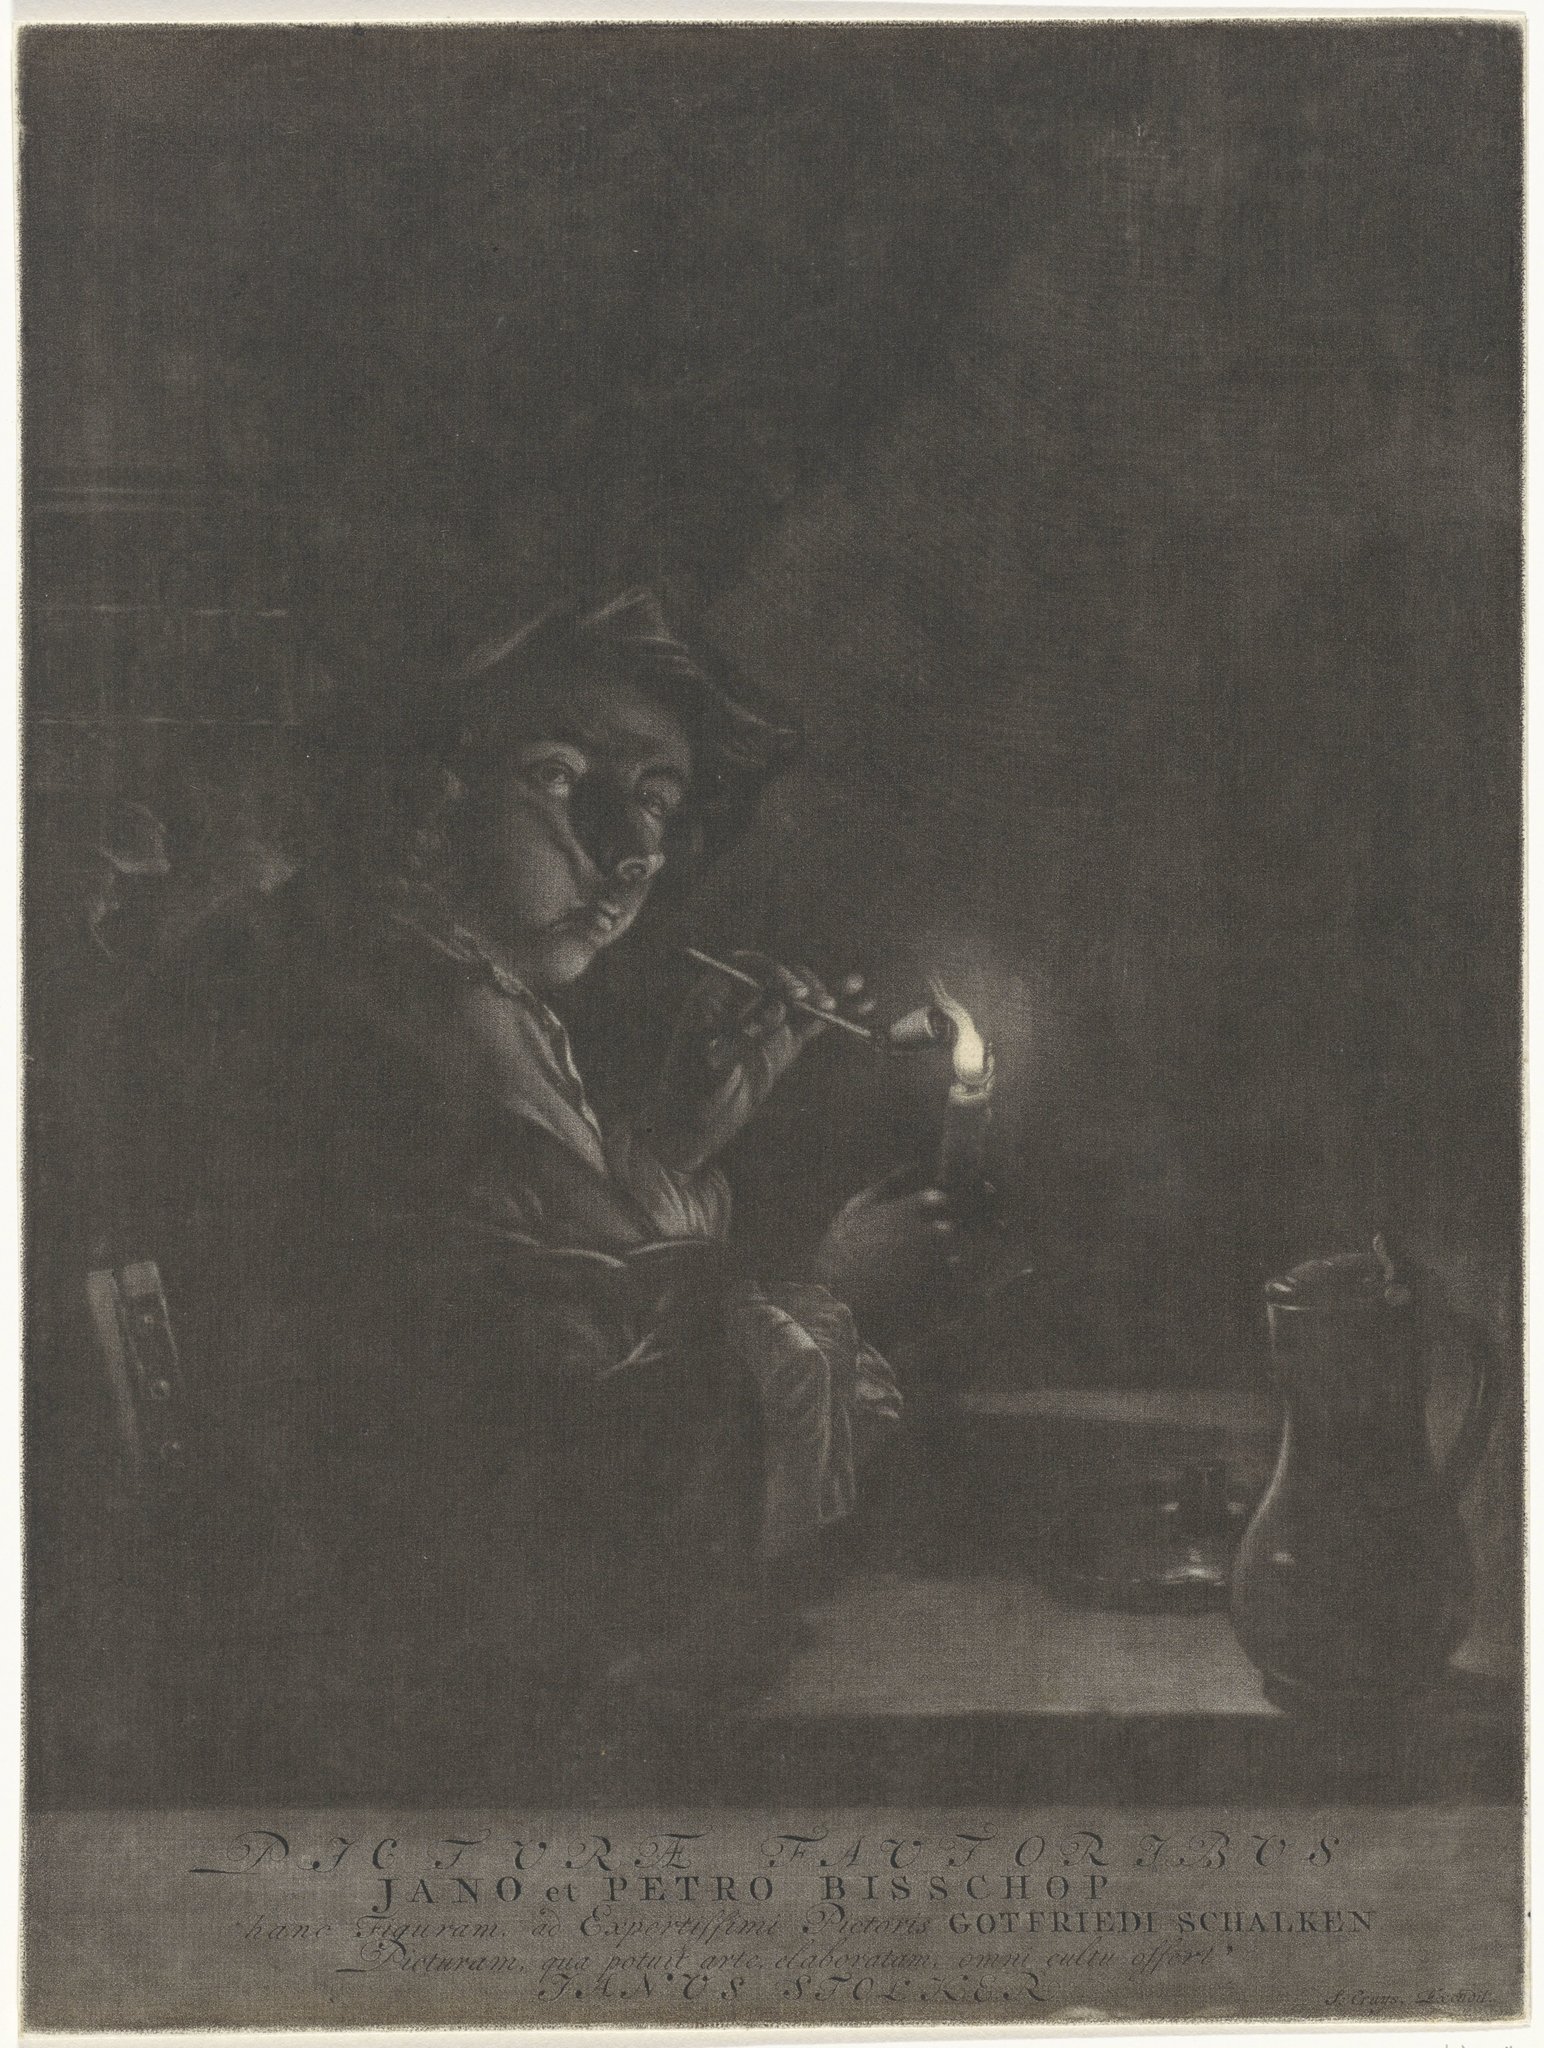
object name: print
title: Man steekt zijn pijp op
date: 1734-1785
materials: paper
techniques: engraving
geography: northern netherlands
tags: pipe ~ tobacco, candlestick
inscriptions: collector's mark: Lugt 2228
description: Een jonge man steekt zijn pijp op met een kaars. Hij zit op een stoel aan een tafel waarop een kan.